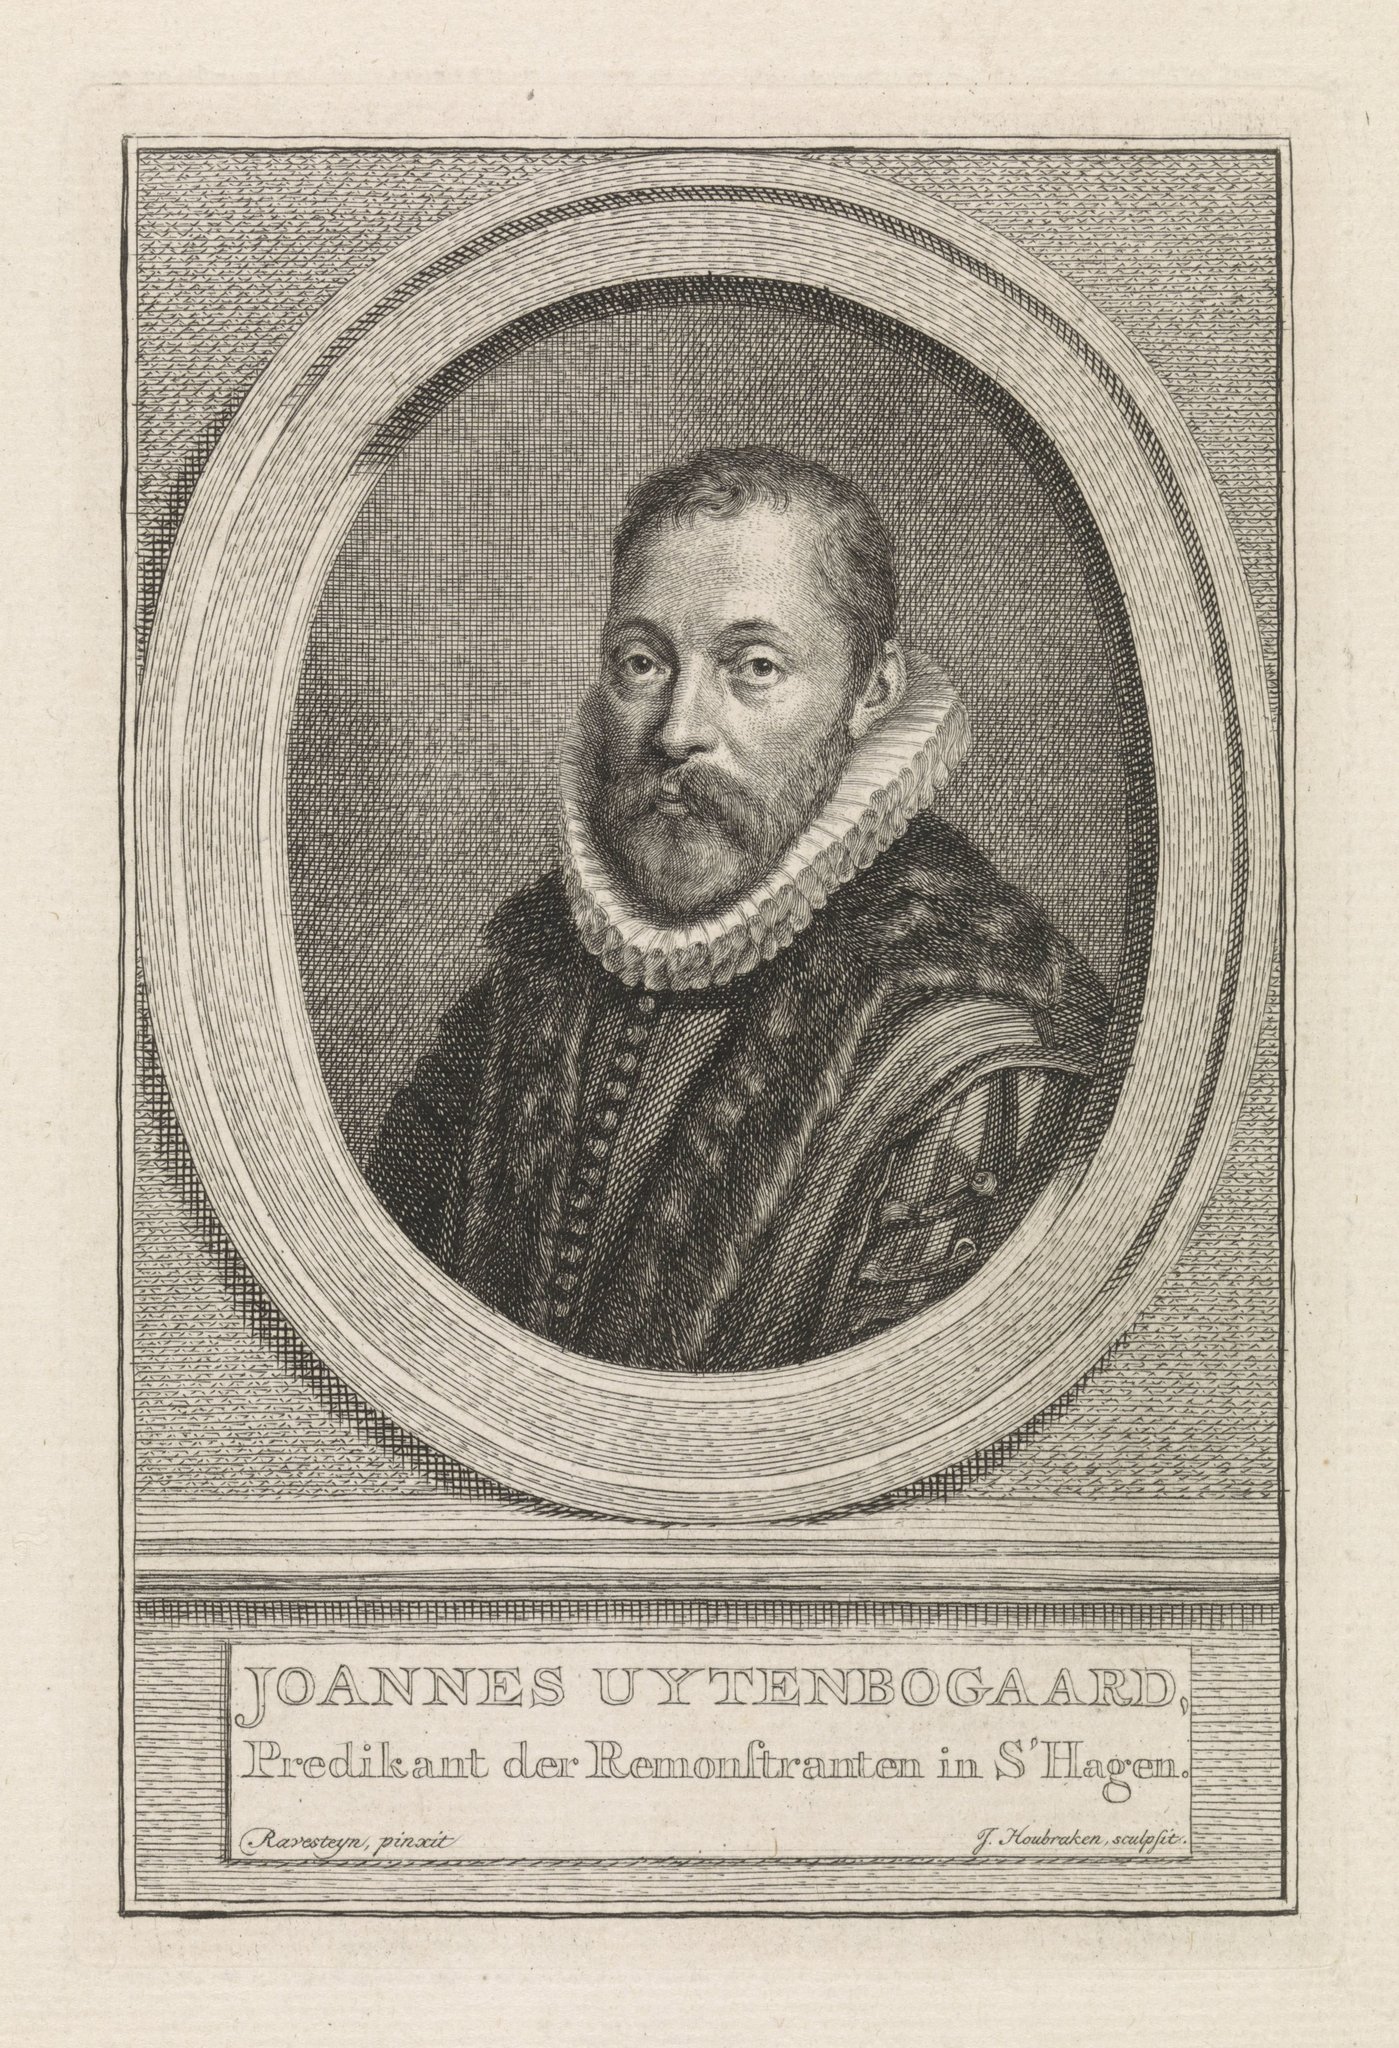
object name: print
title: Portret van Johannes Wtenbogaert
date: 1749-1780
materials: paper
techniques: engraving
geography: amsterdam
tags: utrecht, the hague, historical persons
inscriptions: collector's mark: Lugt 2228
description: Deze prent is oorspronkelijk bedoeld als aanvulling op Jan Wagenaars ‘Vaderlandsche historie’* en was zo vanaf 1796 verkrijgbaar bij Johannes Allart te Amsterdam. Voor de advertentie waarin Allart de 60 portretten en 7 platen, allen gegraveerd door Houbraken, ter aanvulling op Wagenaars ‘Vaderlandsche historie’ aanbiedt, zie RP-P-OB-77.766. *Van dit werk zijn in de achttiende eeuw meerdere uitgaves verschenen, zoals: Wagenaar, Jan. Vaderlandsche historie, vervattende de geschiedenissen der Vereenigde Nederlanden (…). 21 delen. Amsterdam: Isaak Tirion, 1749-1759. Wagenaar, Jan. Vaderlandsche historie, vervattende de geschiedenissen der nu Vereenigde Nederlanden (…). 21 delen. Amsterdam: weduwe Isaak Tirion, 1770. Wagenaar, Jan. Vaderlandsche historie, vervattende de geschiedenissen der nu Vereenigde Nederlanden (…). 21 delen. Amsterdam, Leiden, Dordrecht en Harlingen: P. Schouten e.a., 1782. Wagenaar, Jan. Vaderlandsche historie, vervattende de geschiedenissen der nu Vereenigde Nederlanden (…). 21 delen. Amsterdam: Johannes Allart, 1790-1796.